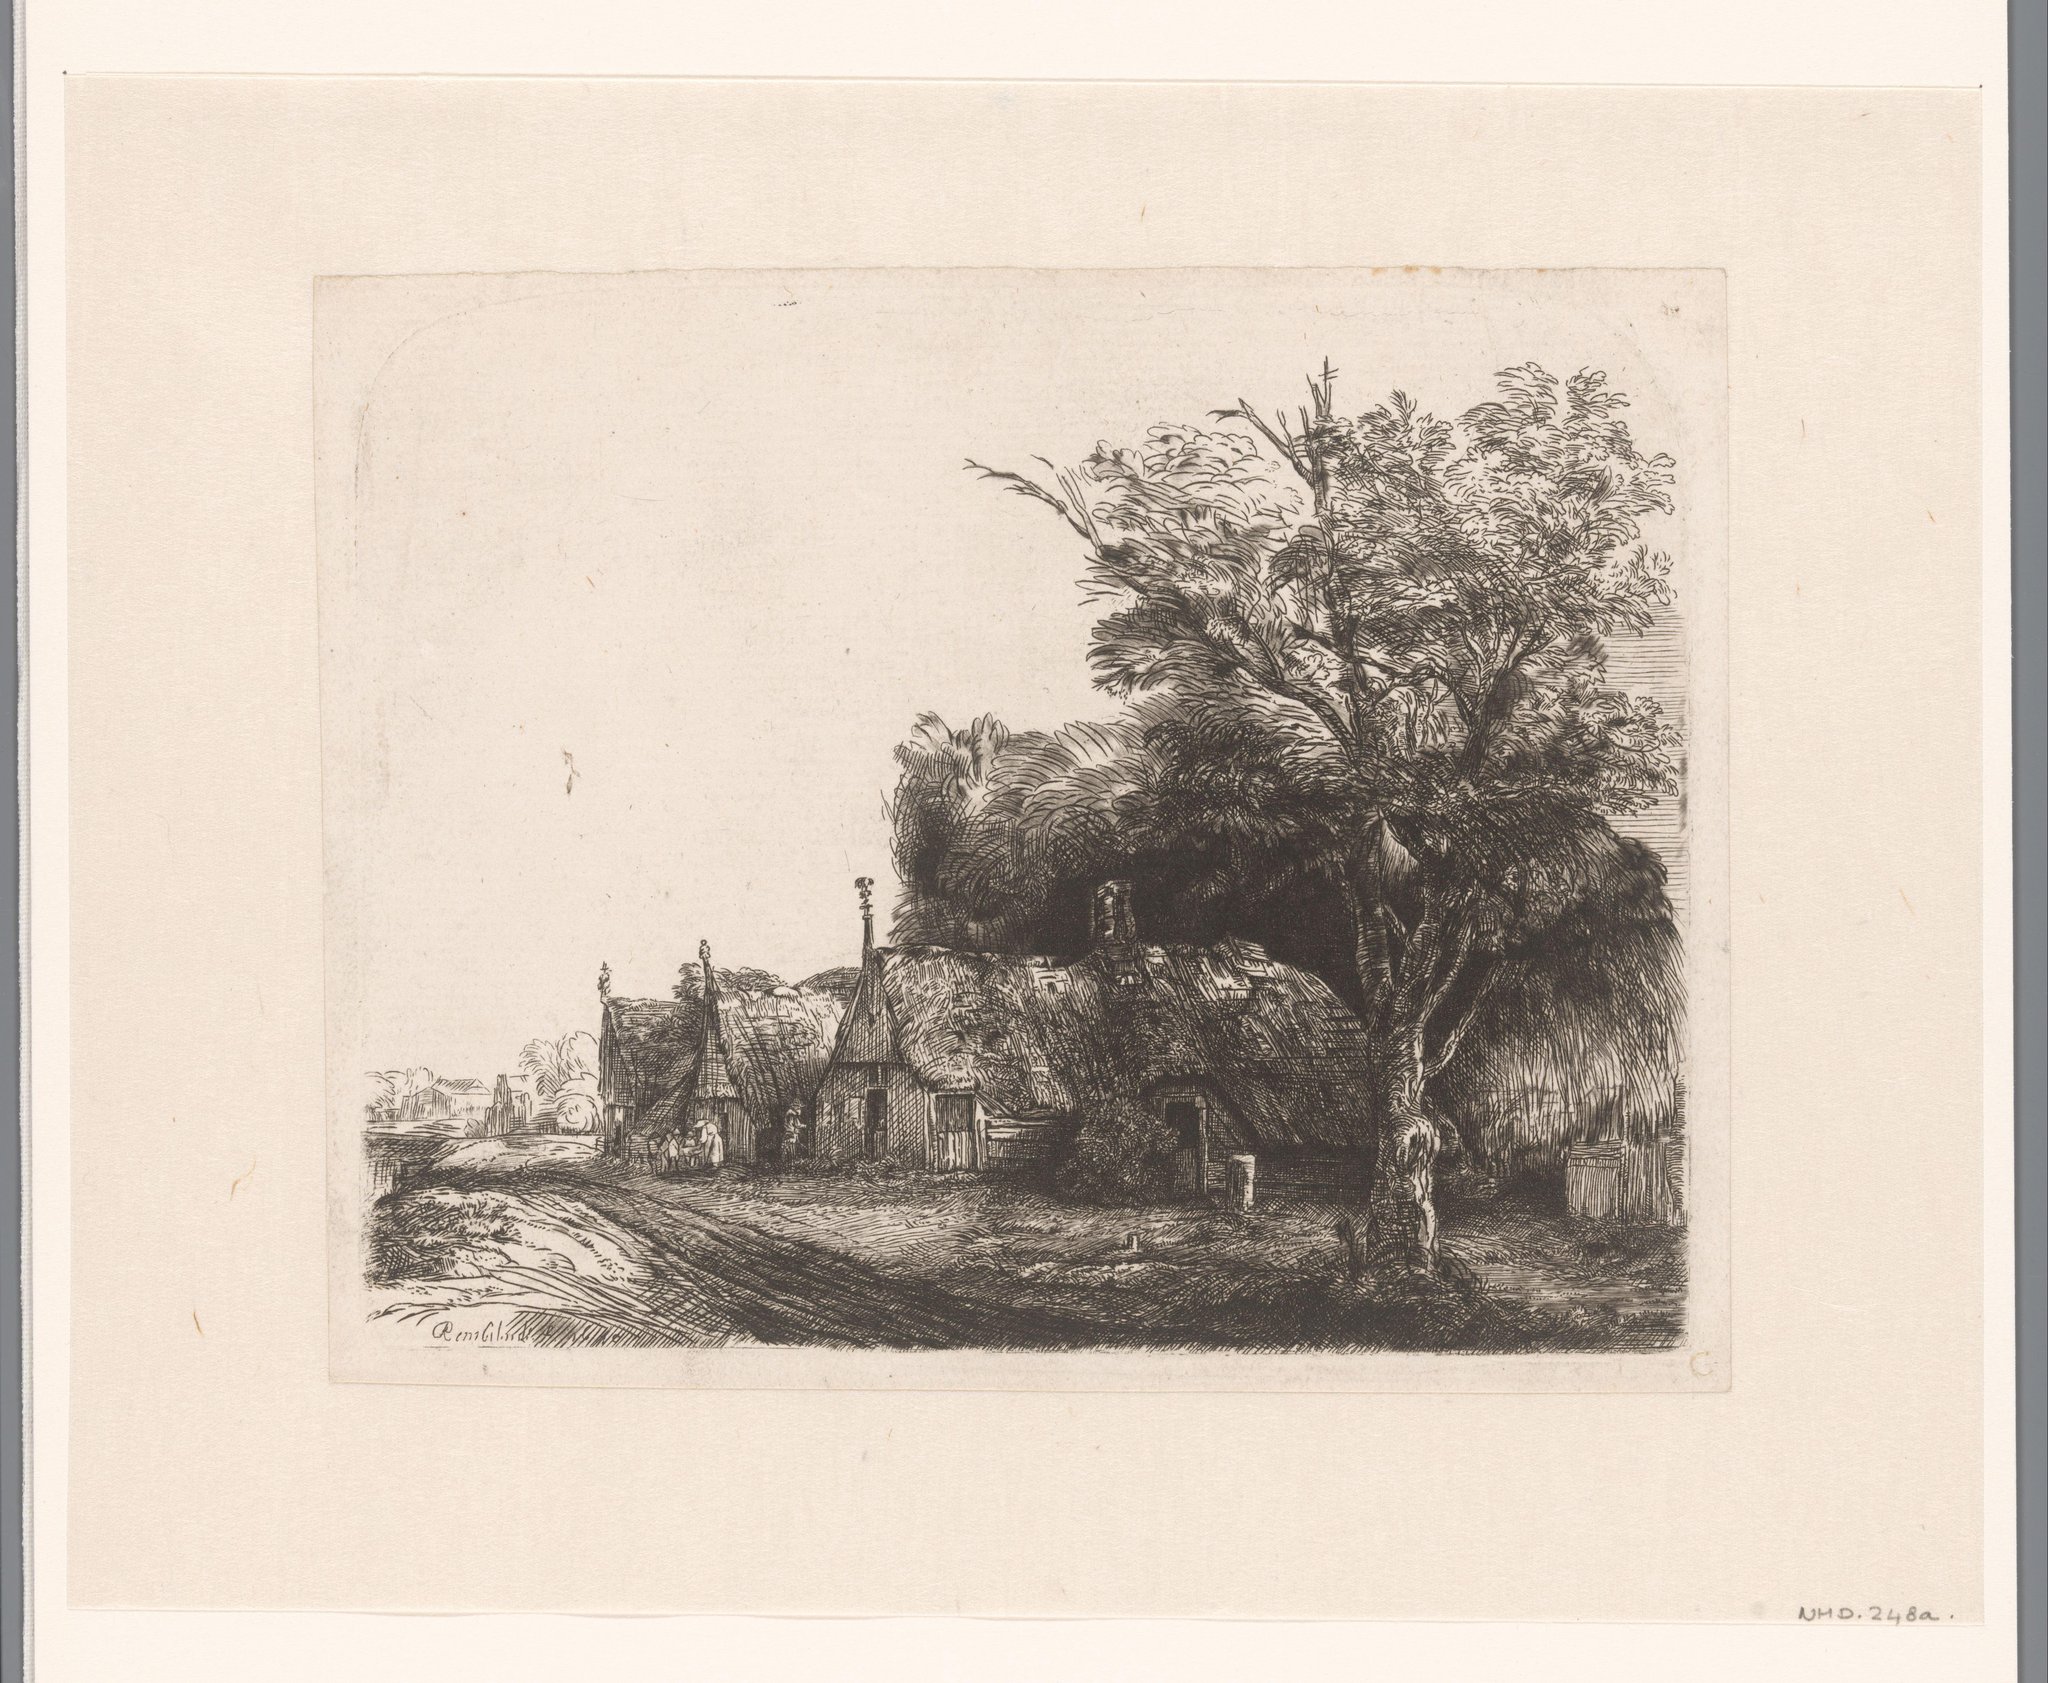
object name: print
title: Landscape with three gabled cottages beside a road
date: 1750-1775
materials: paper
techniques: etching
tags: city-view, and landscape with man-made constructions, hut, cabin, lodge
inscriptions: collector's mark: Lugt 2228, collector's mark: Lugt 1121, collector's mark: Lugt 2610